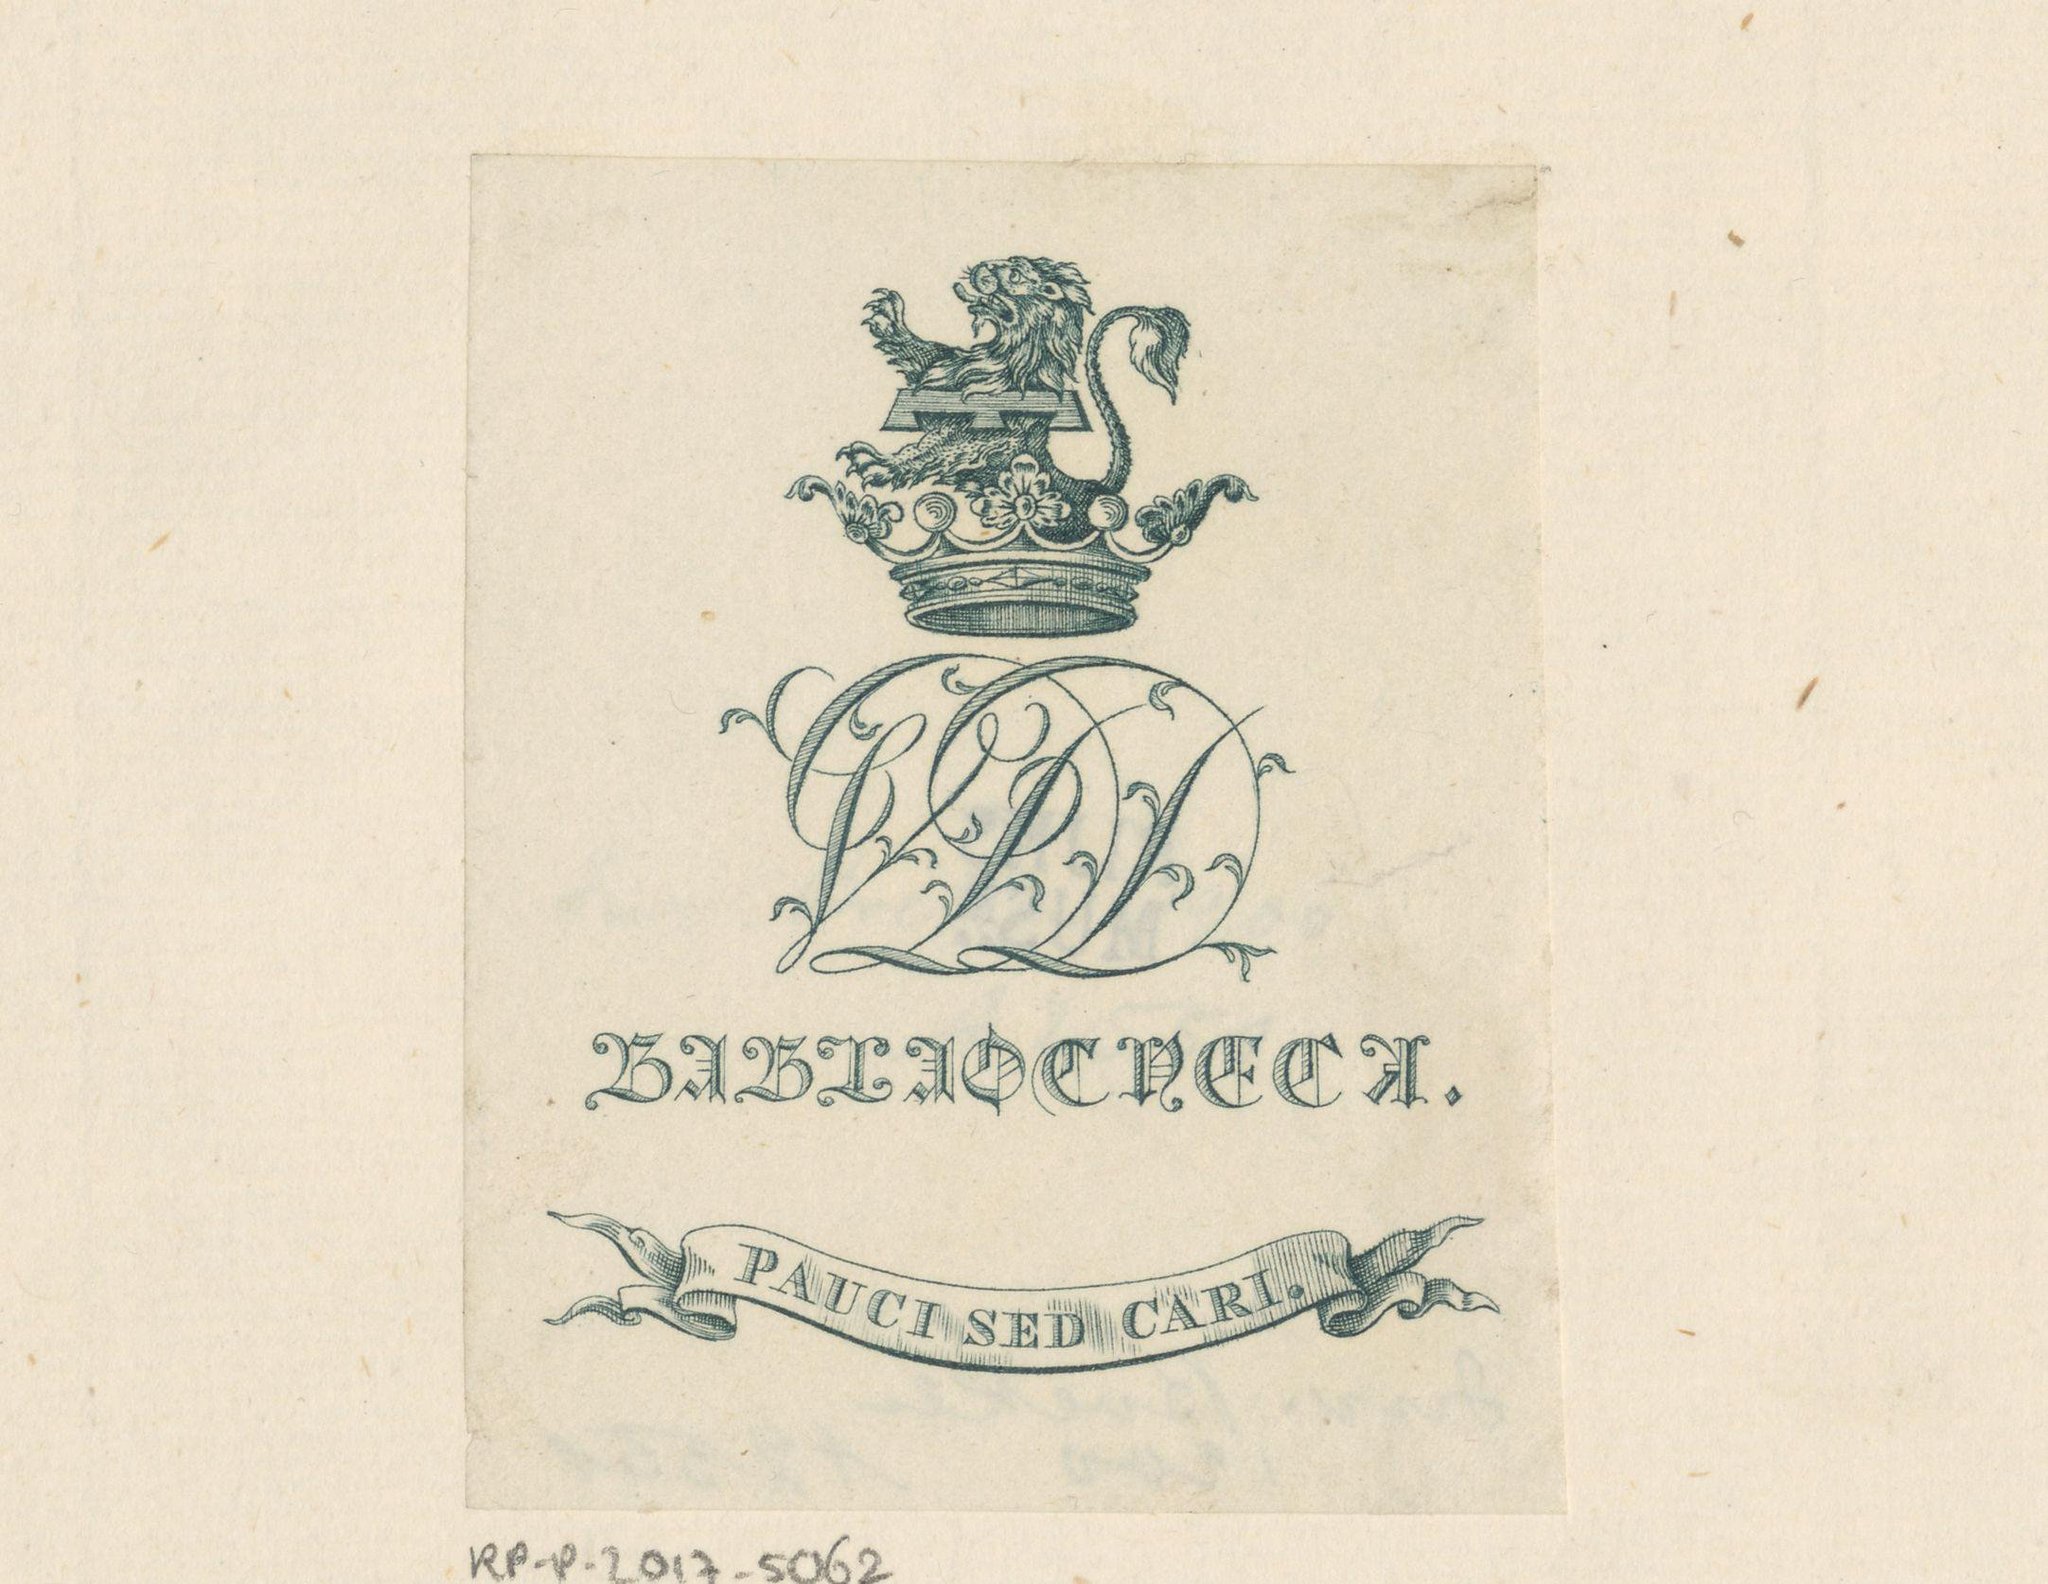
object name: bookplate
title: Ex libris van Van der Duyn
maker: Anonymous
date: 1781-1848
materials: paper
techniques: etching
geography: netherlands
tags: deventer, the hague, adam françois jules armand van der duyn, beasts of prey, predatory animals: lion, armorial bearing, heraldry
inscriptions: collector's mark: Lugt 2228, inscription: ‘Inv. Boeken / 1900 A2551’